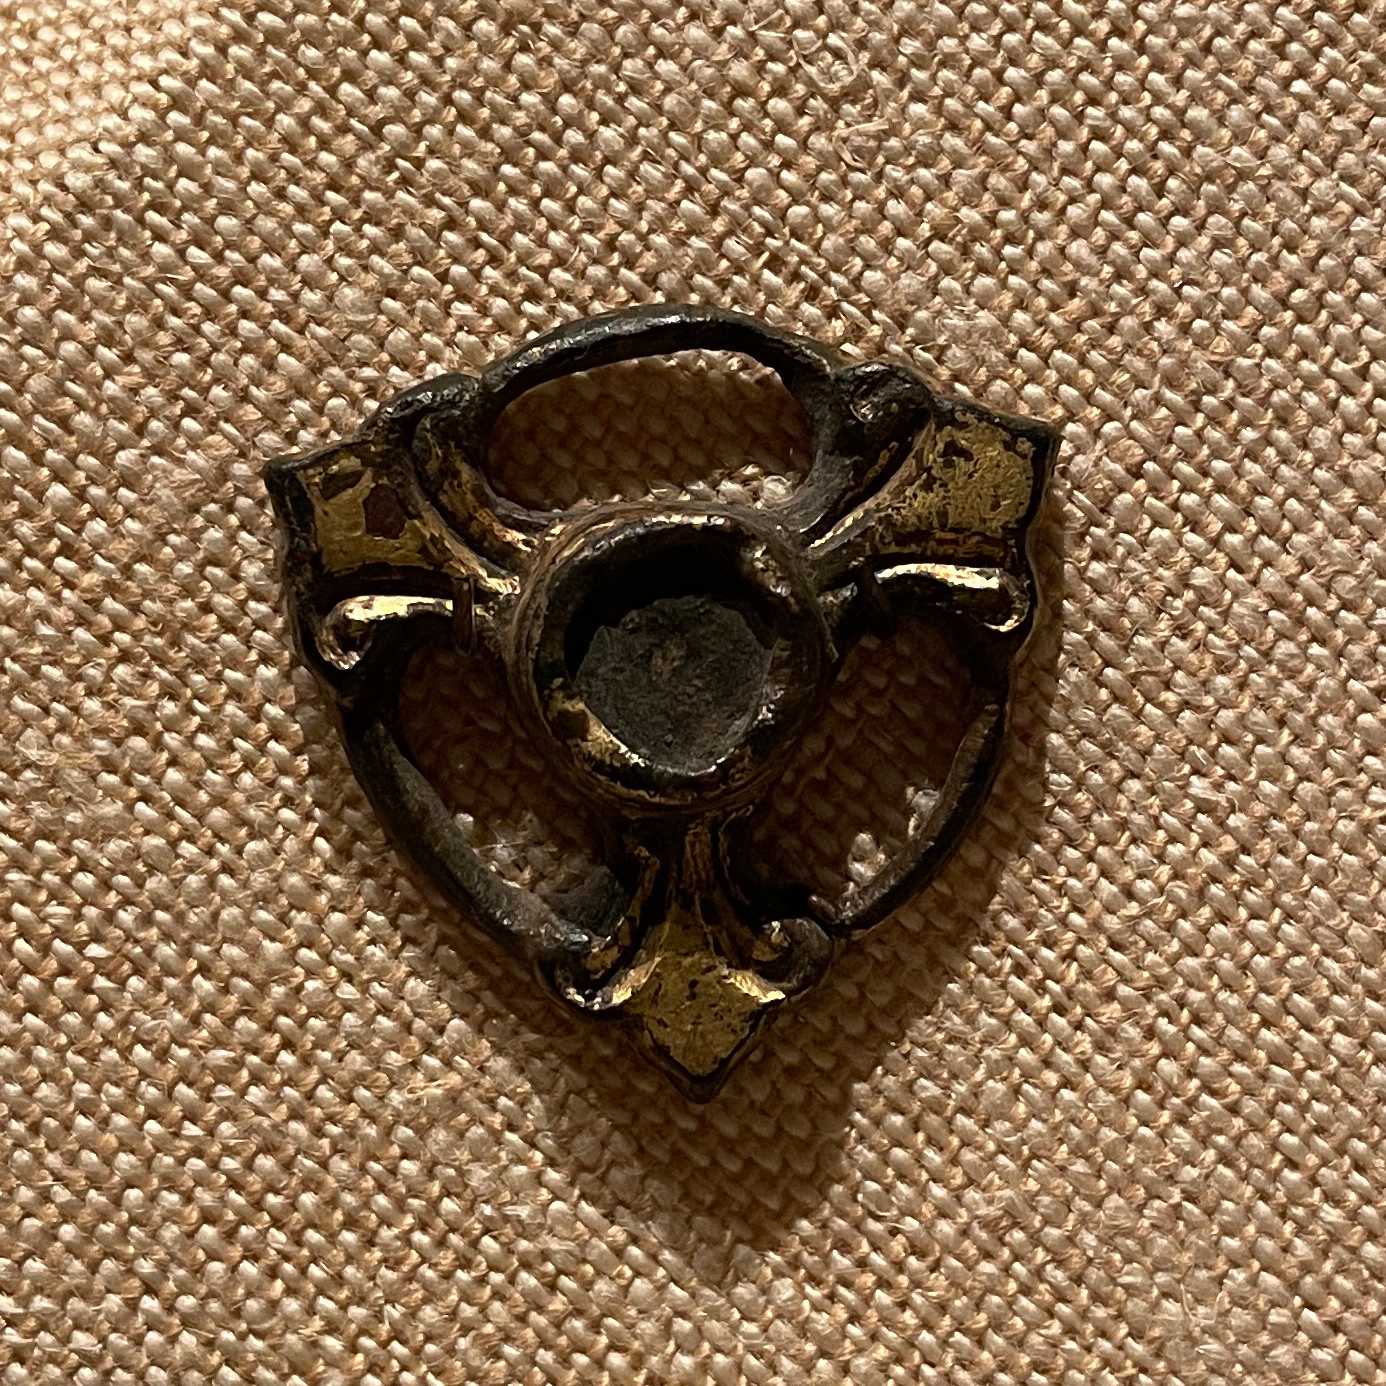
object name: ornament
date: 801-1000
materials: bronze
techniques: casting, gilding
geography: iran